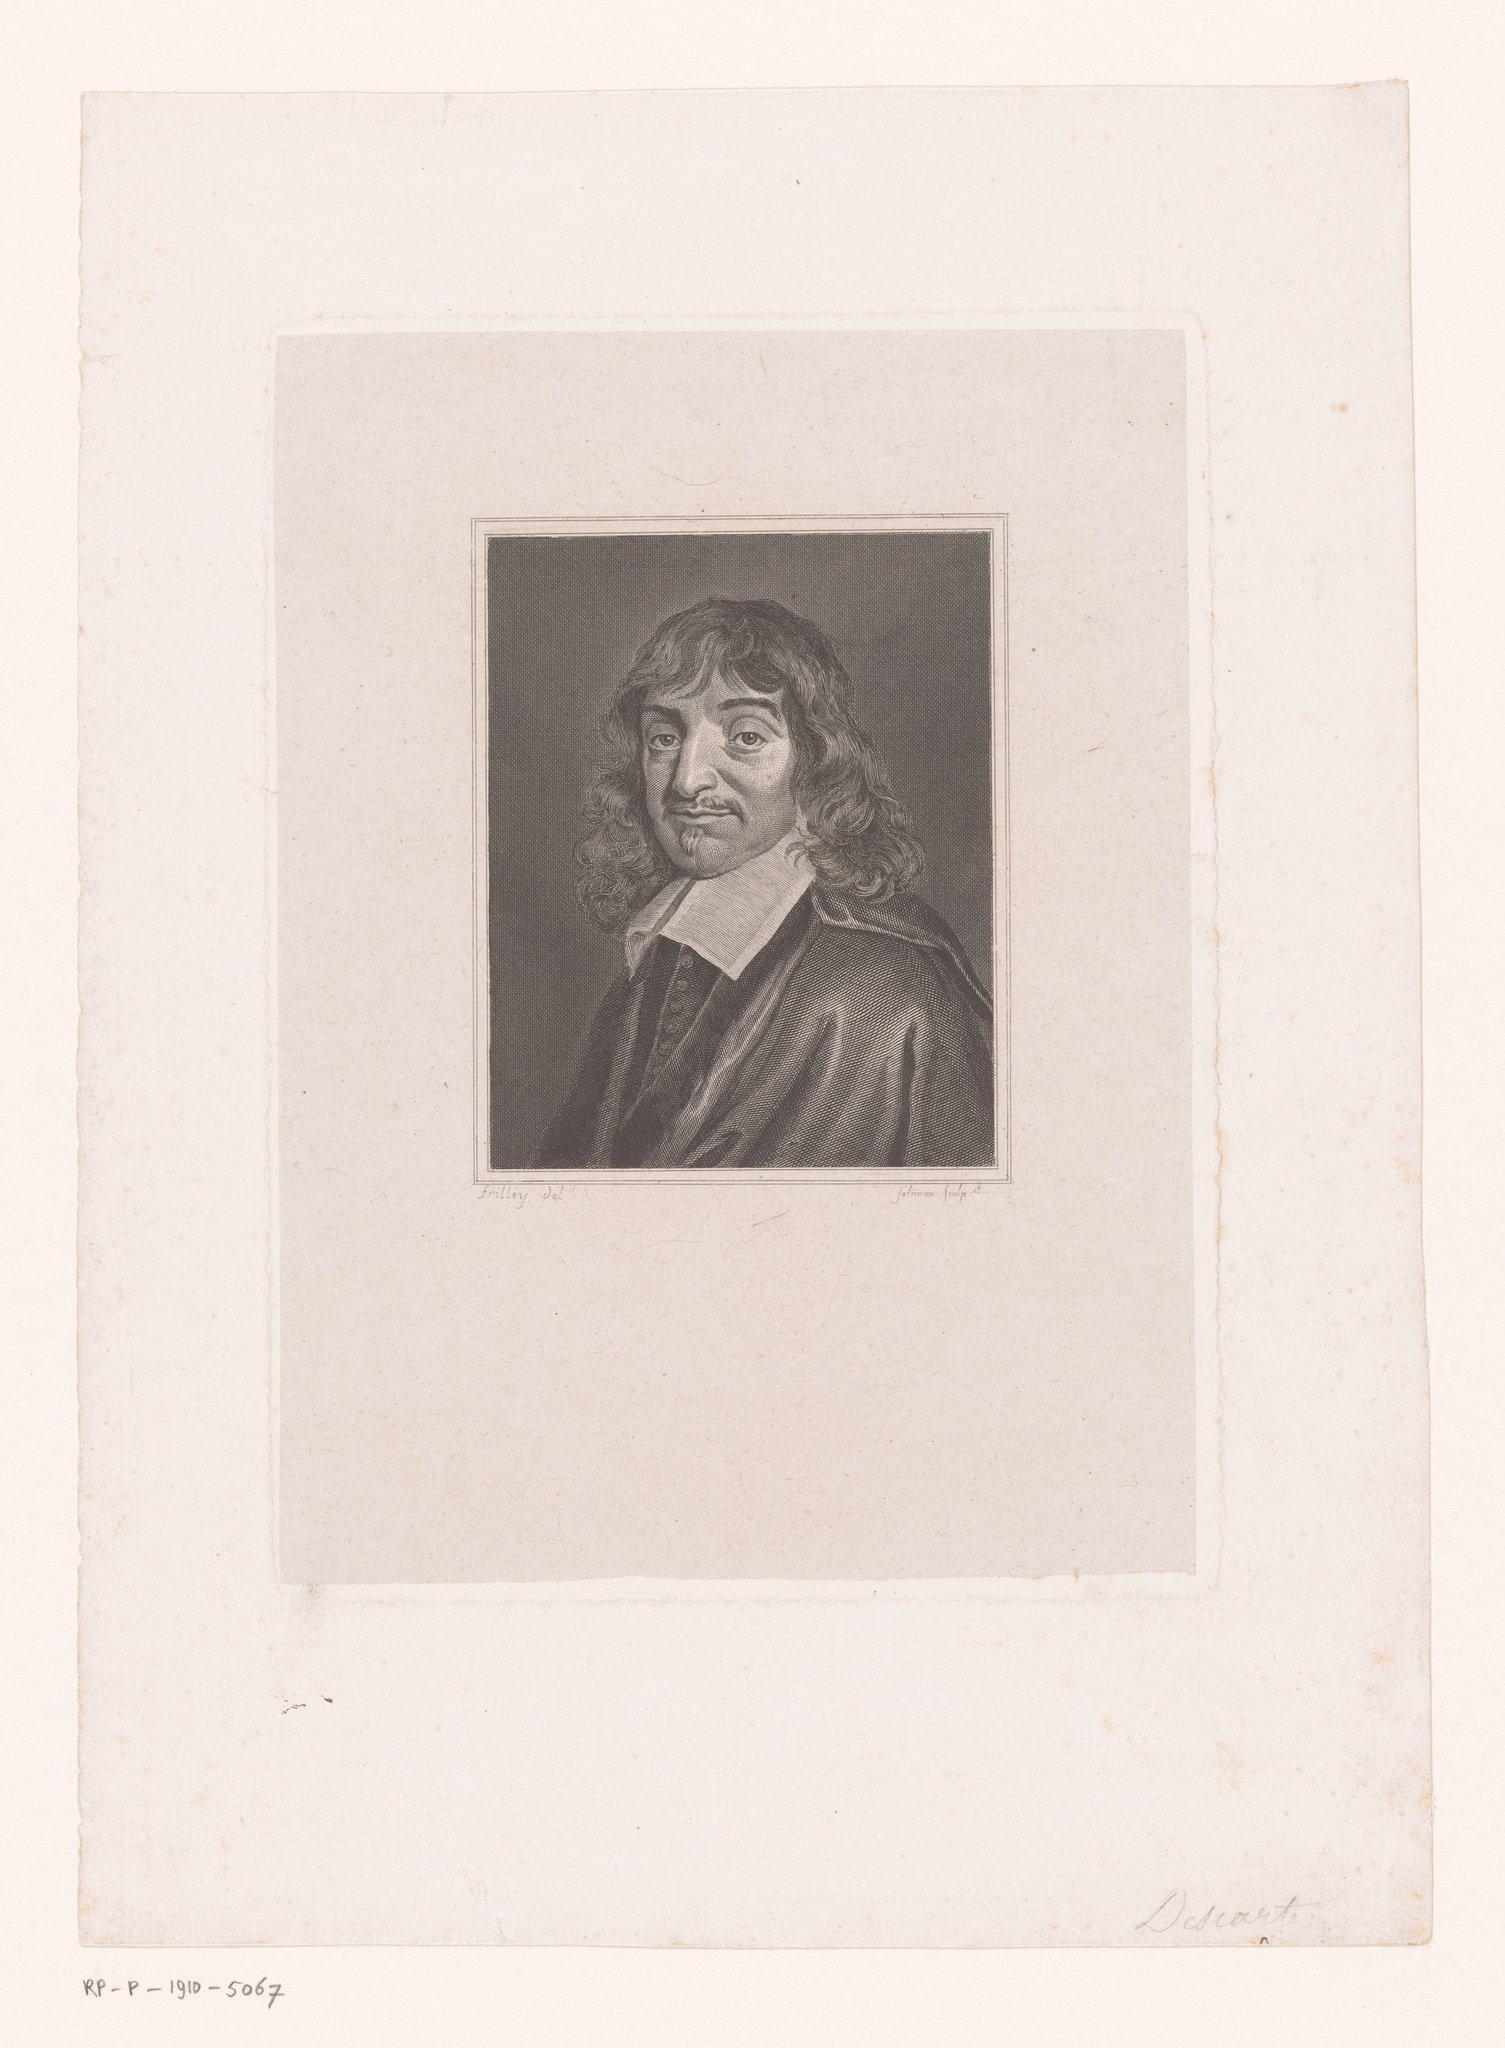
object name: print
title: Portret van René Descartes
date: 1825-1874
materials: paper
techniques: engraving, etching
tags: rené descartes, scholar, philosopher, historical persons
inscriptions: collector's mark: Lugt 2228